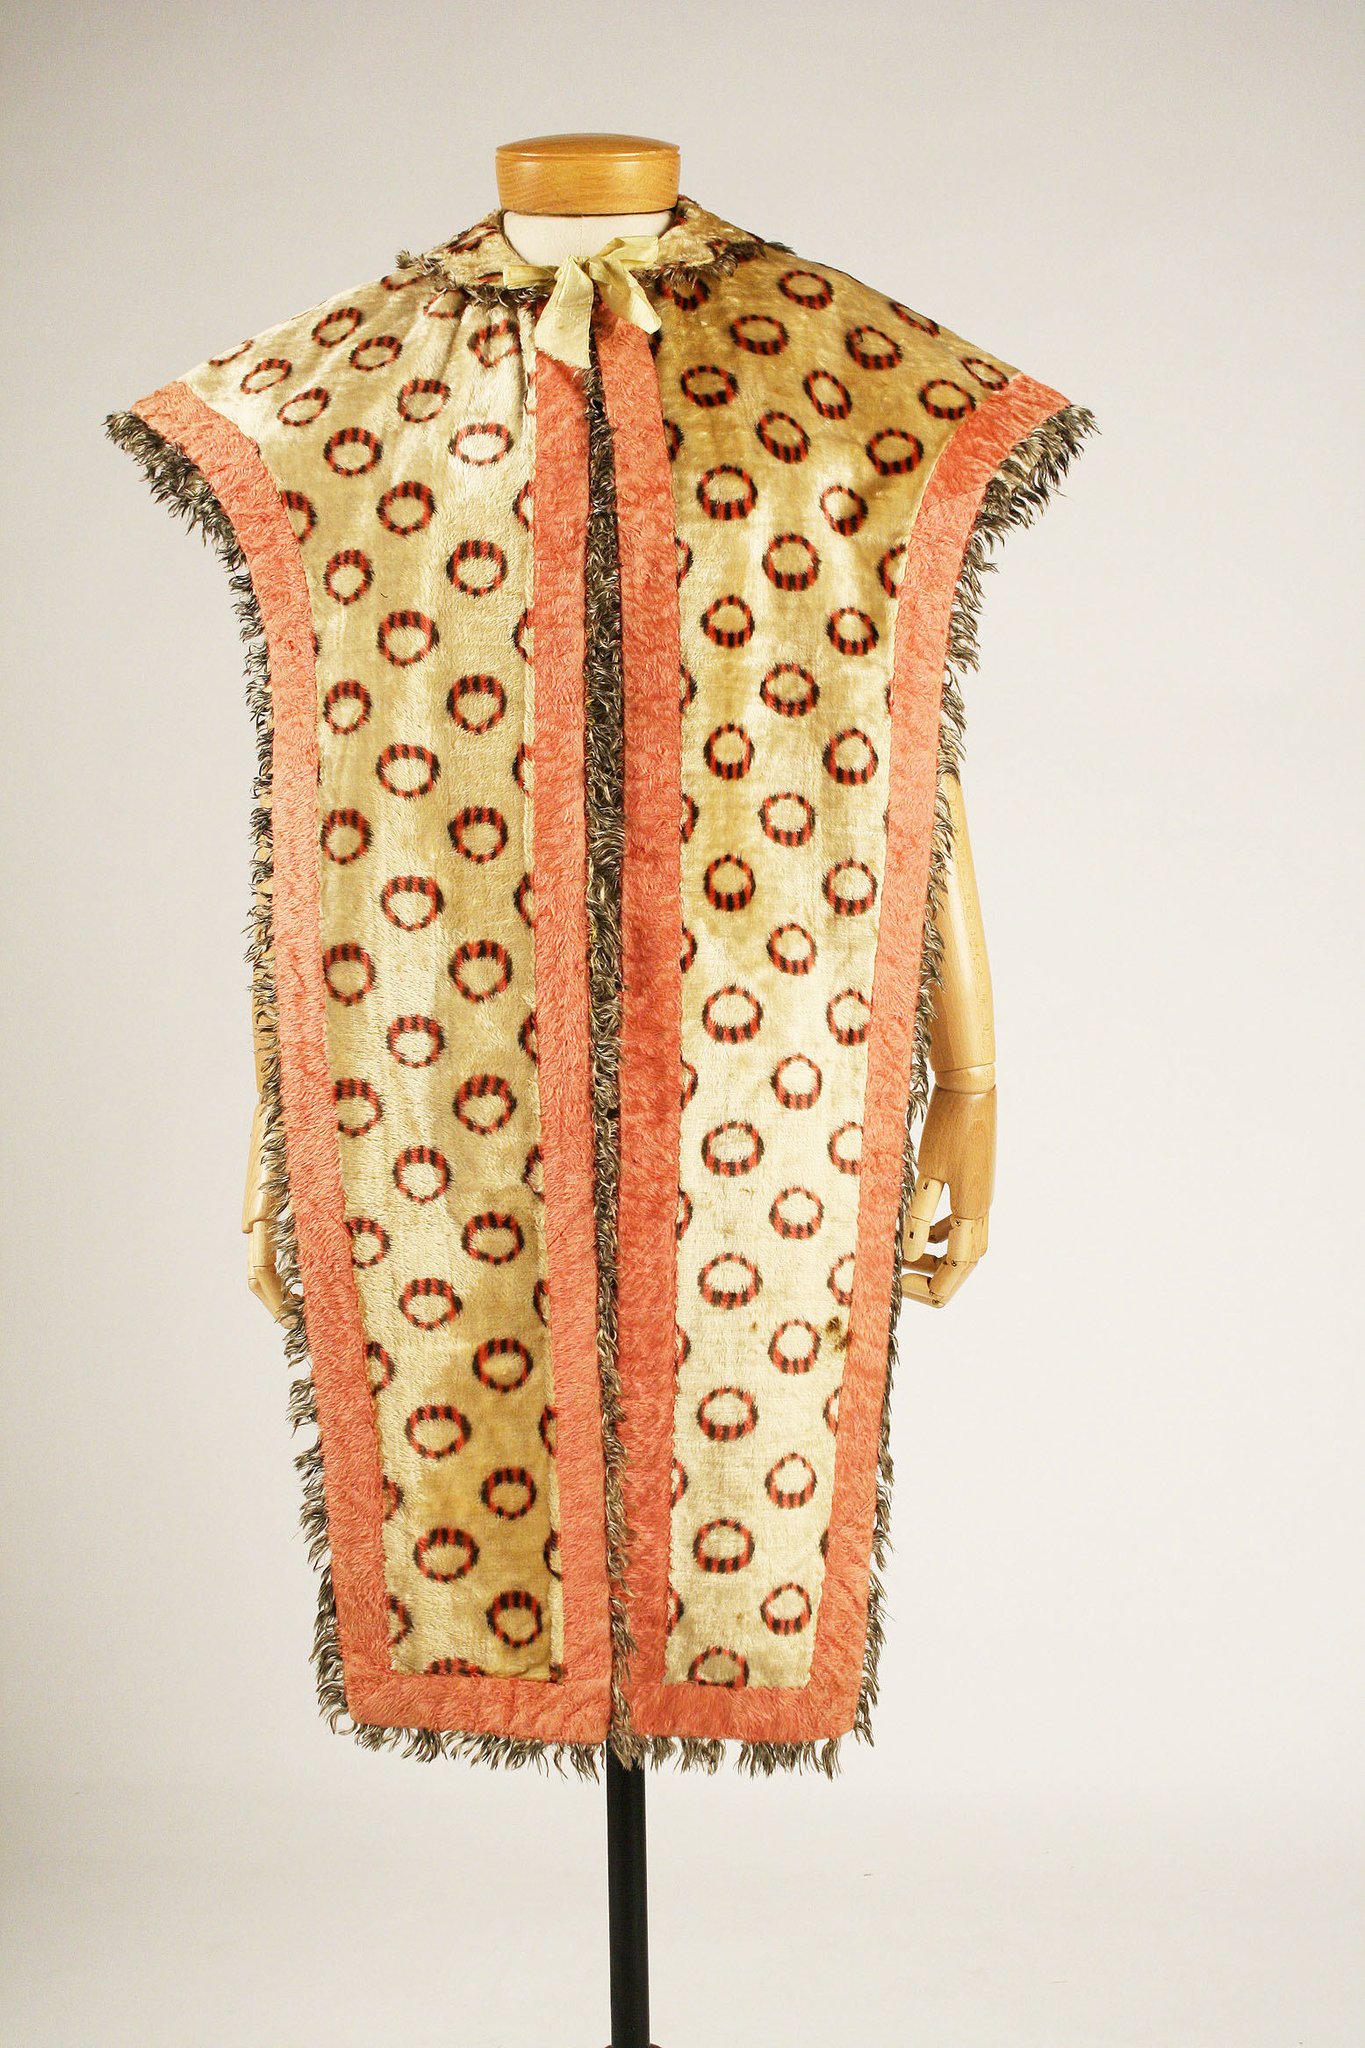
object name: stole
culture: british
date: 1810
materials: silk